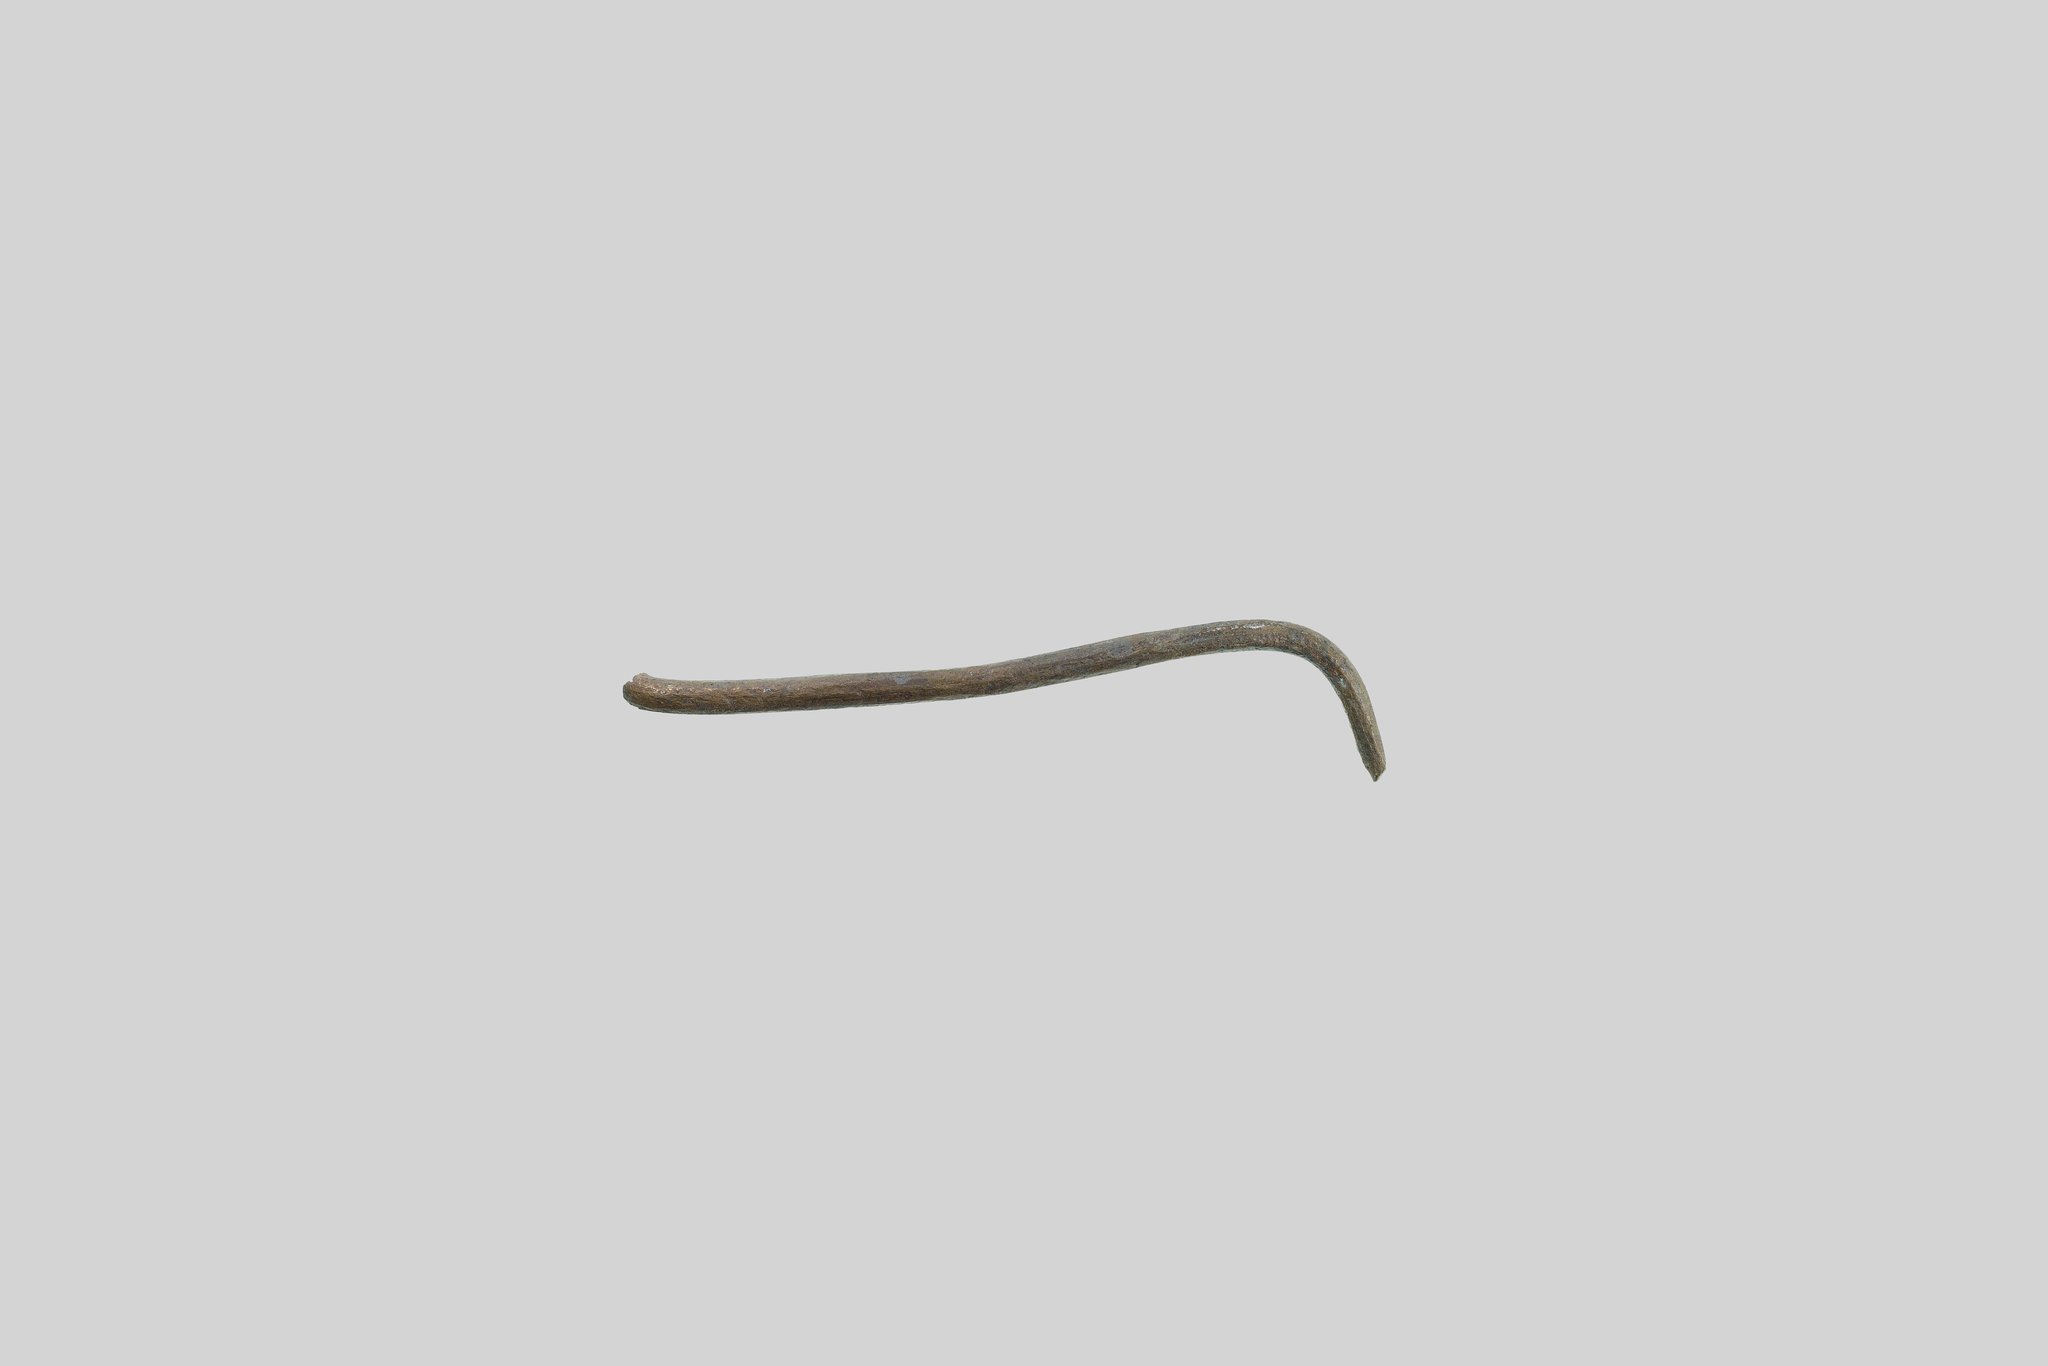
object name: rod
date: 664-332 BCE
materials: copper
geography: egypt